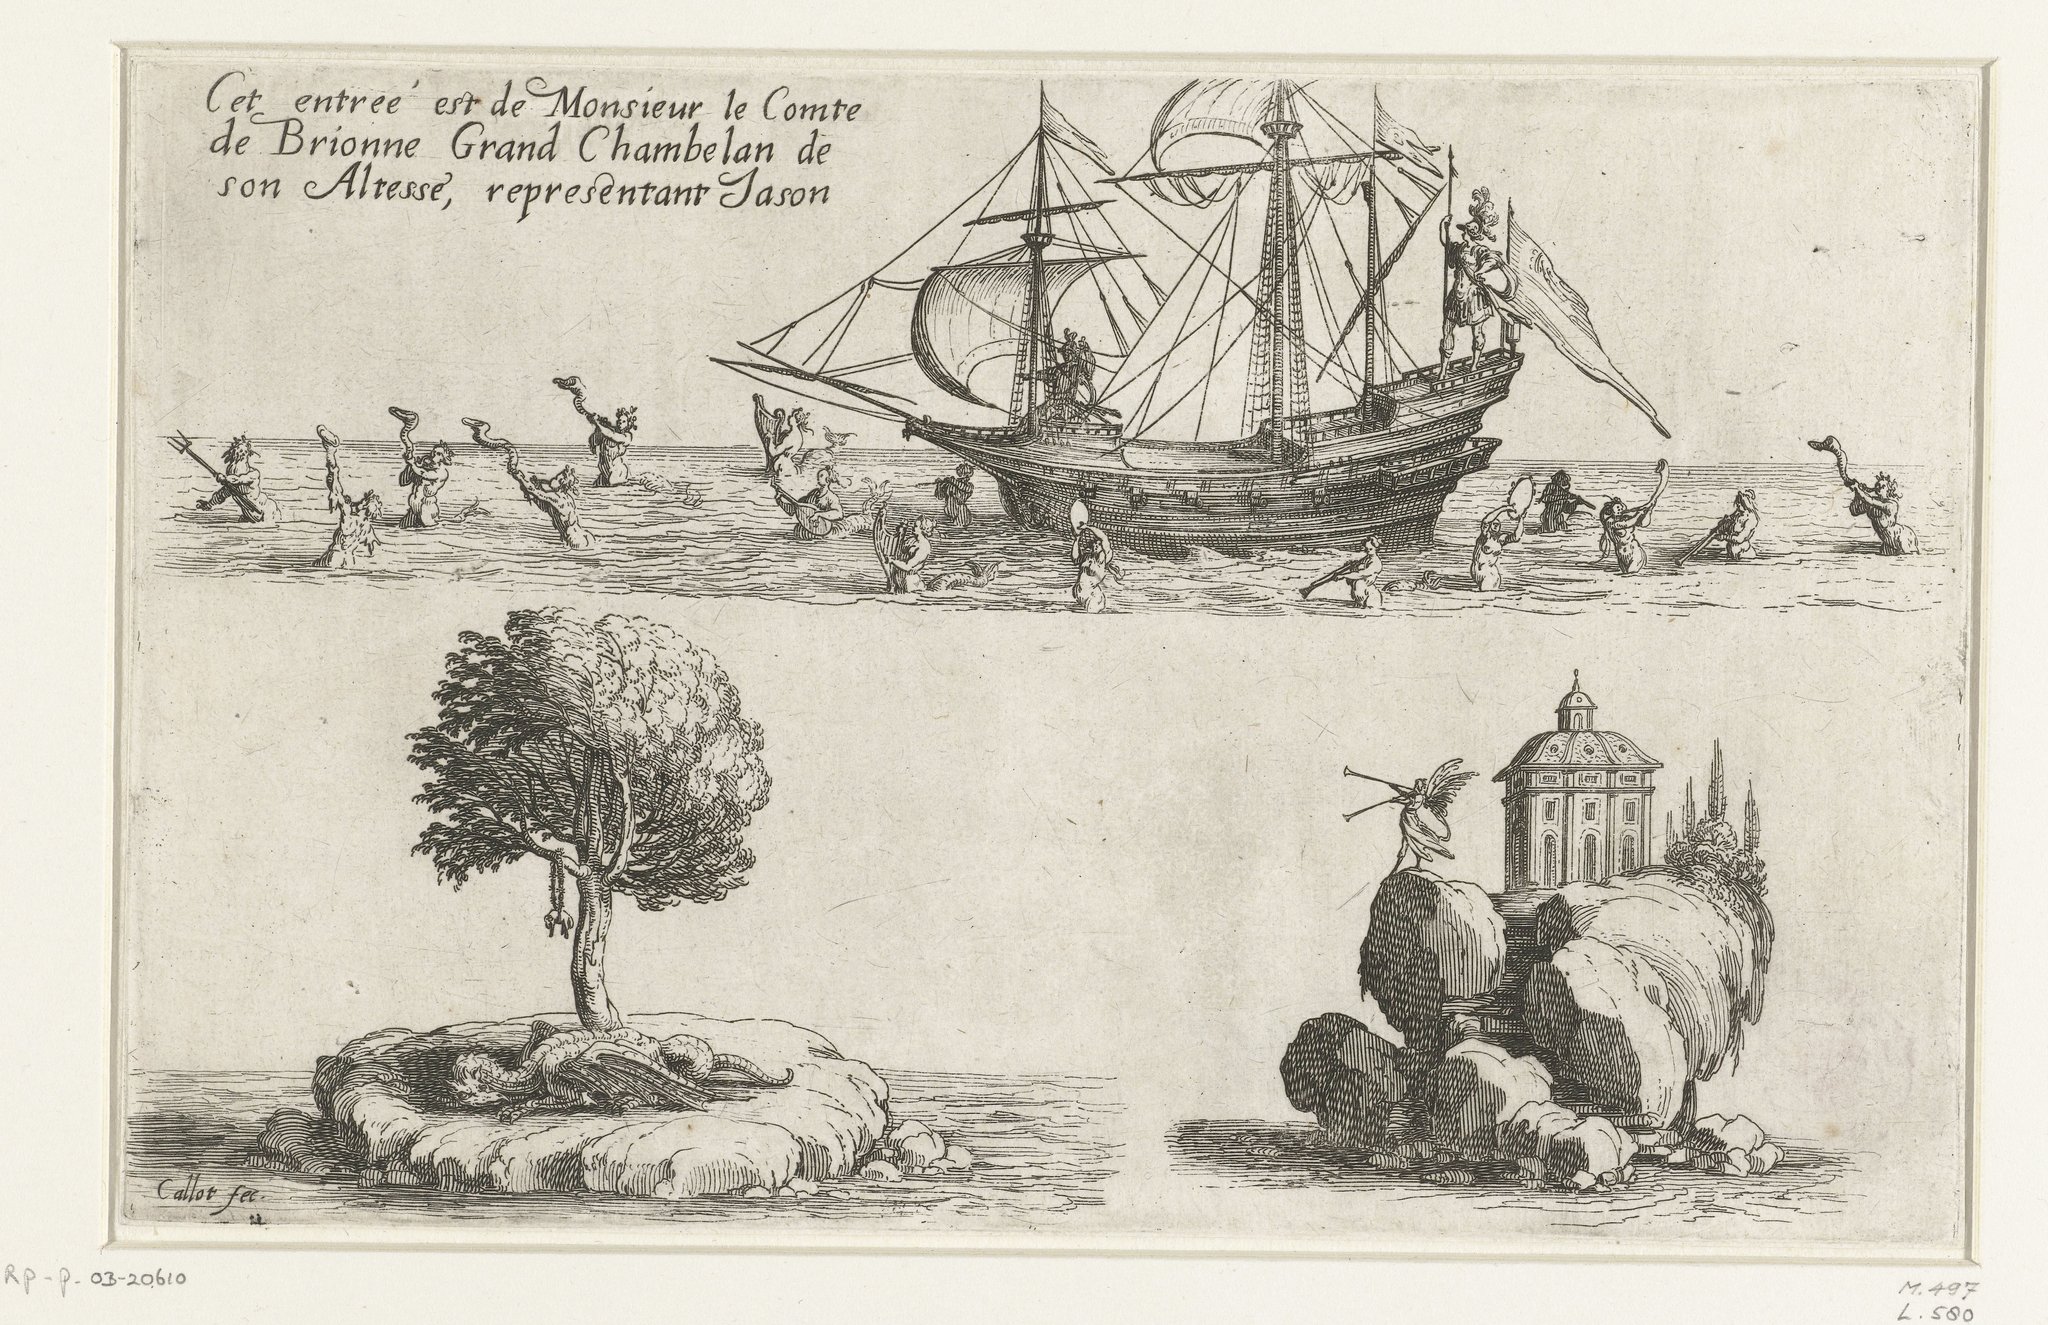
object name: print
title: Cet entreé est de Monsieur le Comte de Brionne Grand Chambelan de son Altesse, representant Jason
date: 1627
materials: paper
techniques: etching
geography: nancy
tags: (story of) neptune (poseidon), musician, triton(s), (story of) jason, ships (in general), fama as roman personification, the story of the argonauts: the quest for the golden fleece, the golden fleece, hanging on an oak-tree, is seized by jason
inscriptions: collector's mark: Lugt 240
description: De heer van Brionne, verkleed als Jason, staand op de achterplecht van een schip dat omgeven is door tritons en musicerende dames, aangevoerd door Poseidon. Daaronder een klein eiland met een draak die een ketting met het gulden vlies eraan bewaakt. Daarnaast een rotsachtig eiland met een huis erop, waarvoor de Faam staat. Boven de voorstelling een opschrift in het Frans. Deze prent is onderdeel van een serie illustraties voor een boek over de festiviteiten (o.a. een toernooi) in het hertogelijk paleis te Nancy op 14 februari 1627.